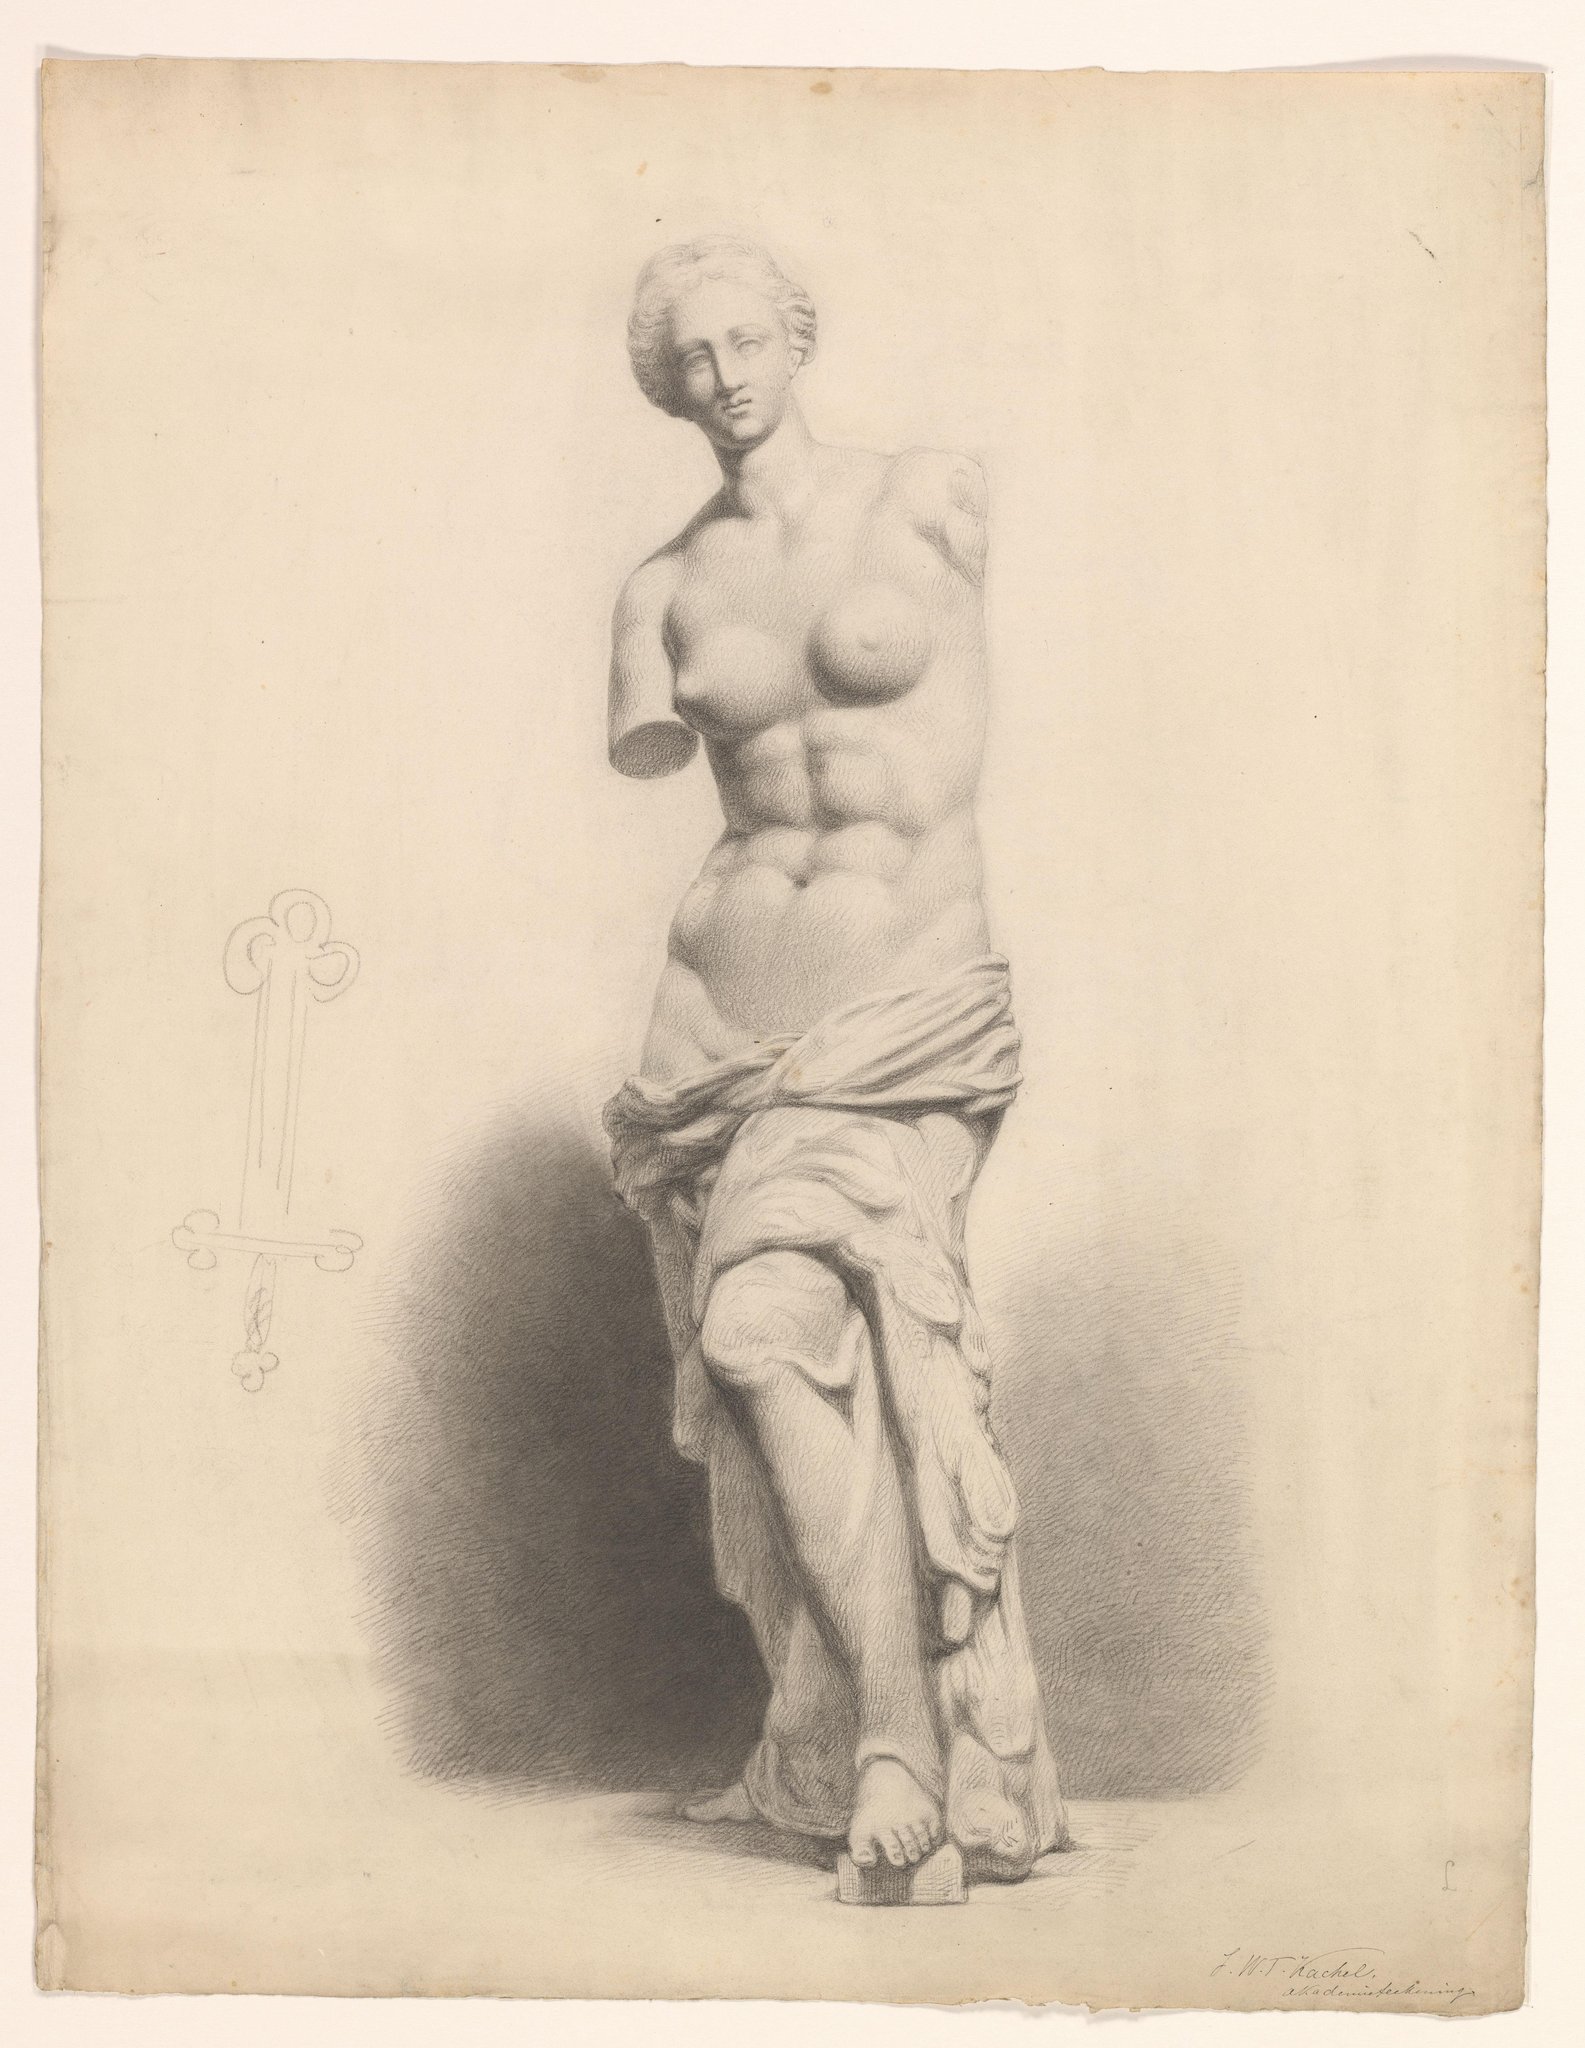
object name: drawing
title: Venus de Milo, van voren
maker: jacobus everhardus josephus van den berg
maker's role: draughtsman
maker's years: 1802-1861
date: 1812-1861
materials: chalk, paper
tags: piece of sculpture, reproduction of a piece of sculpture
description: Academiestudie naar pleistermodel van antiek beeld.